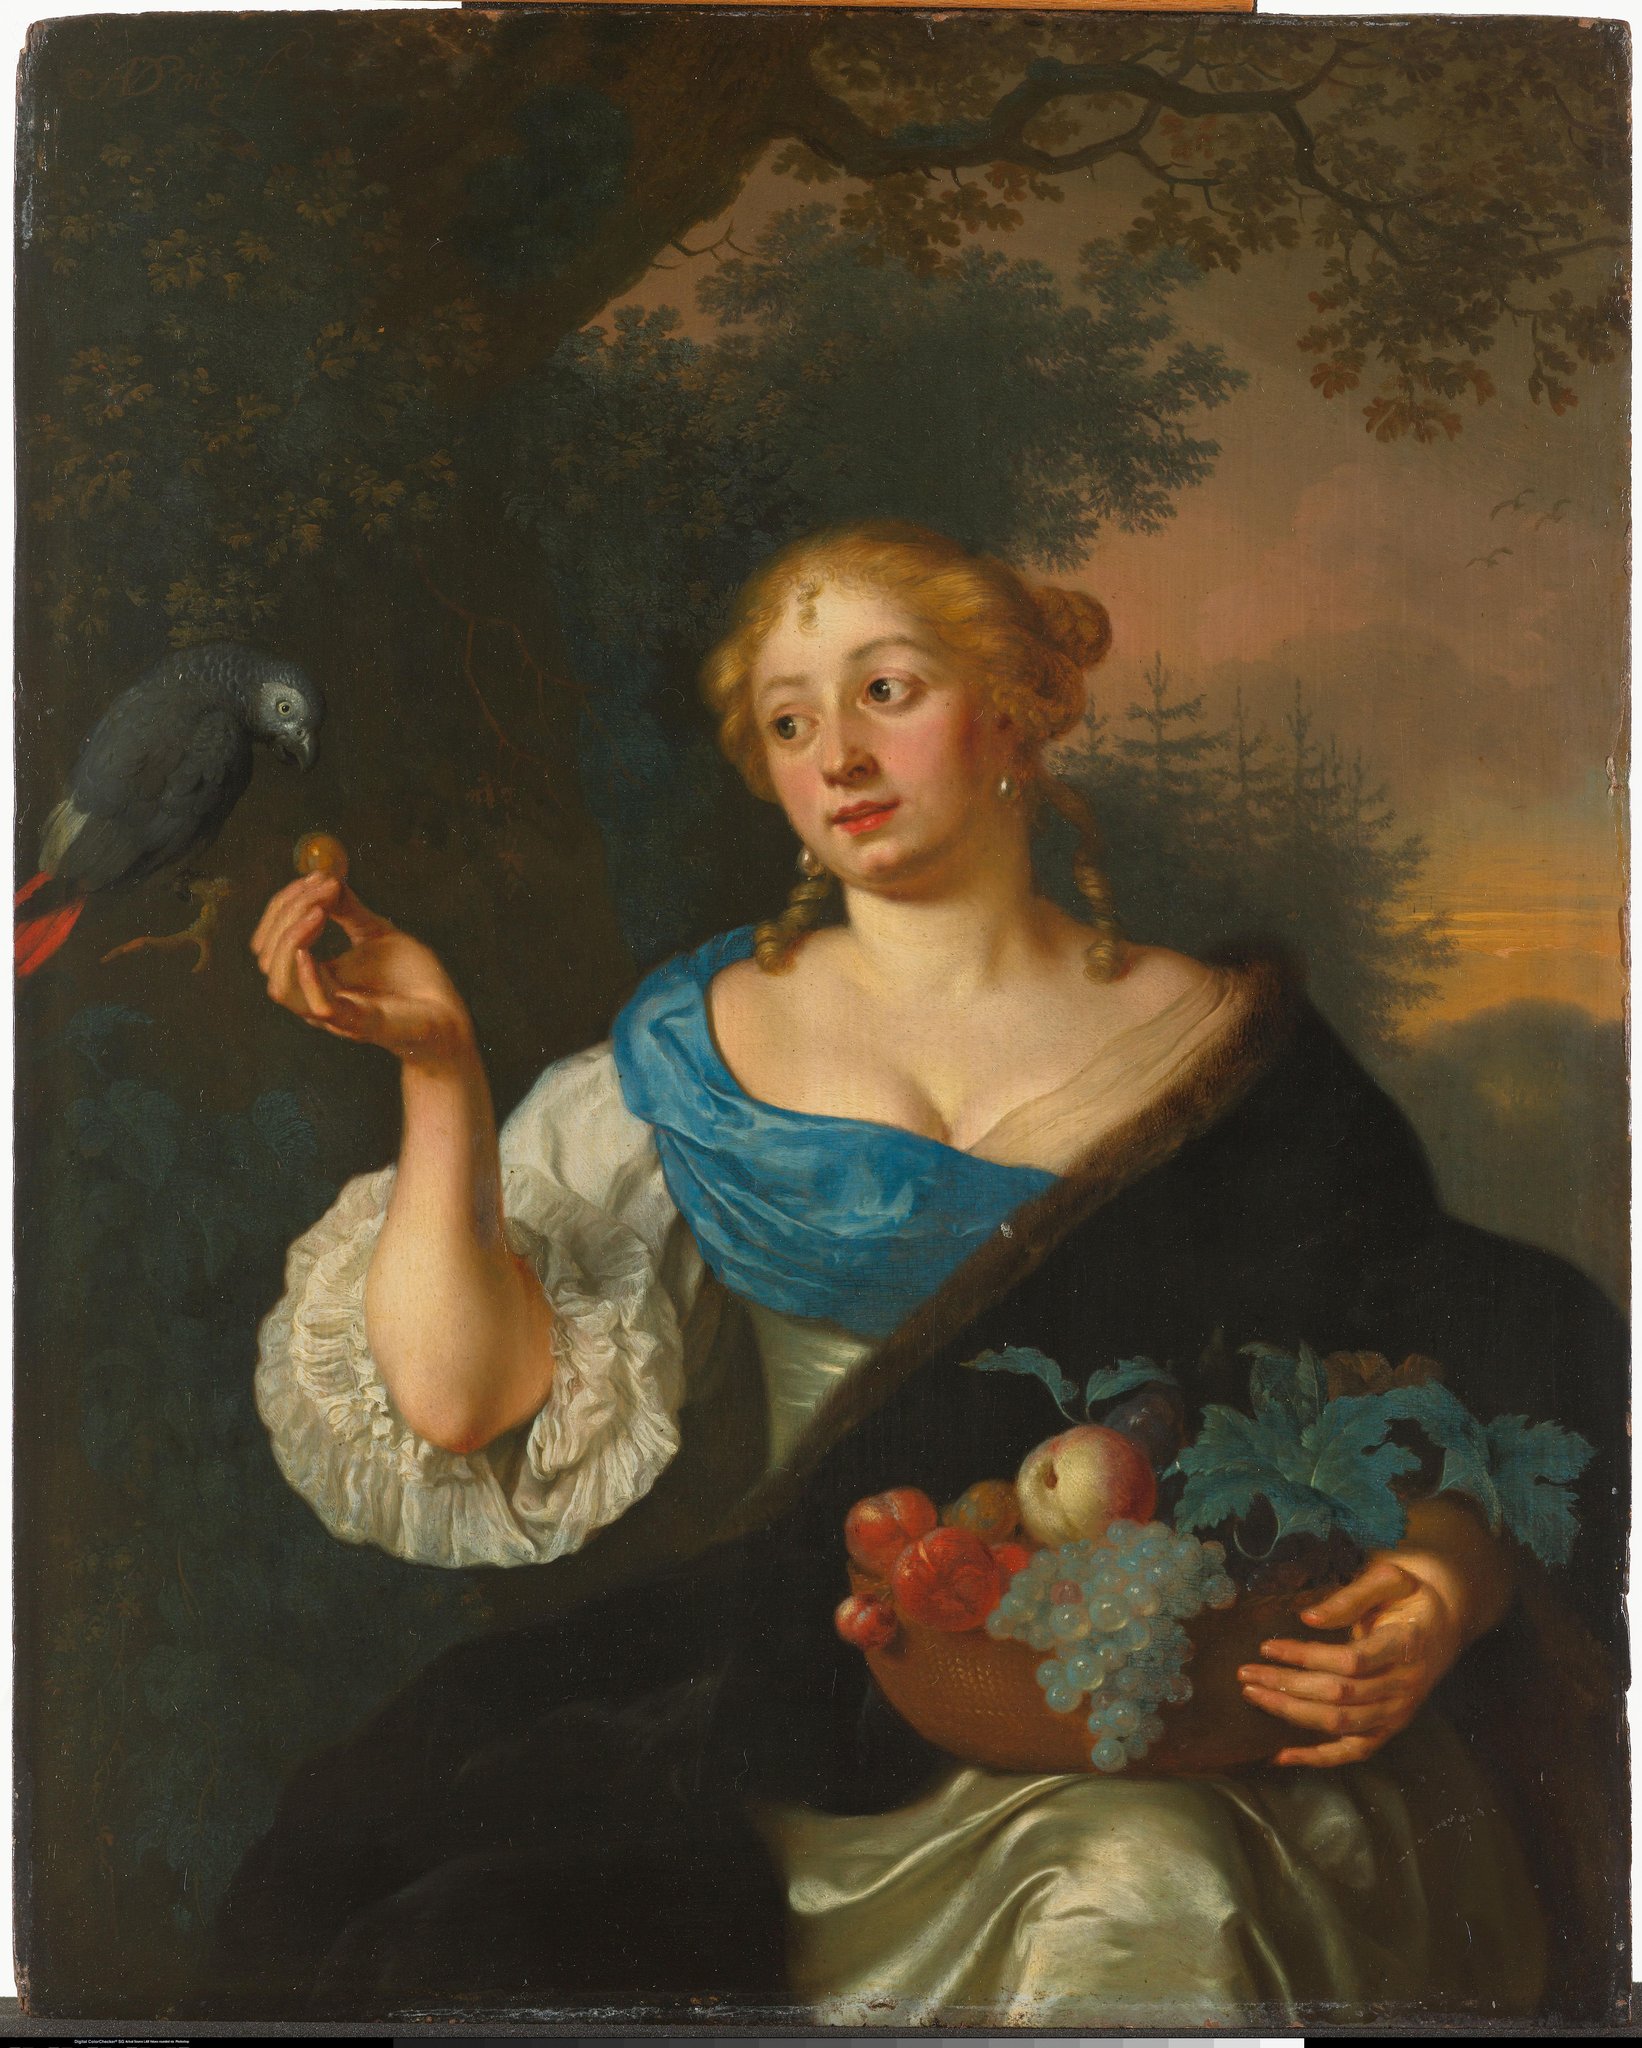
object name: painting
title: A young Woman with a Parrot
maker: ary de vois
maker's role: painter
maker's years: 1632-1680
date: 1660-1680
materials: oil, panel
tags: adolescent, young woman, maiden, adult woman, fruit, ornamental birds: parrot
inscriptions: signature: ‘ADVois f.’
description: Een jonge vrouw zittend met een mand met fruit op schoot onder een boom, geeft een druif aan een papegaai.